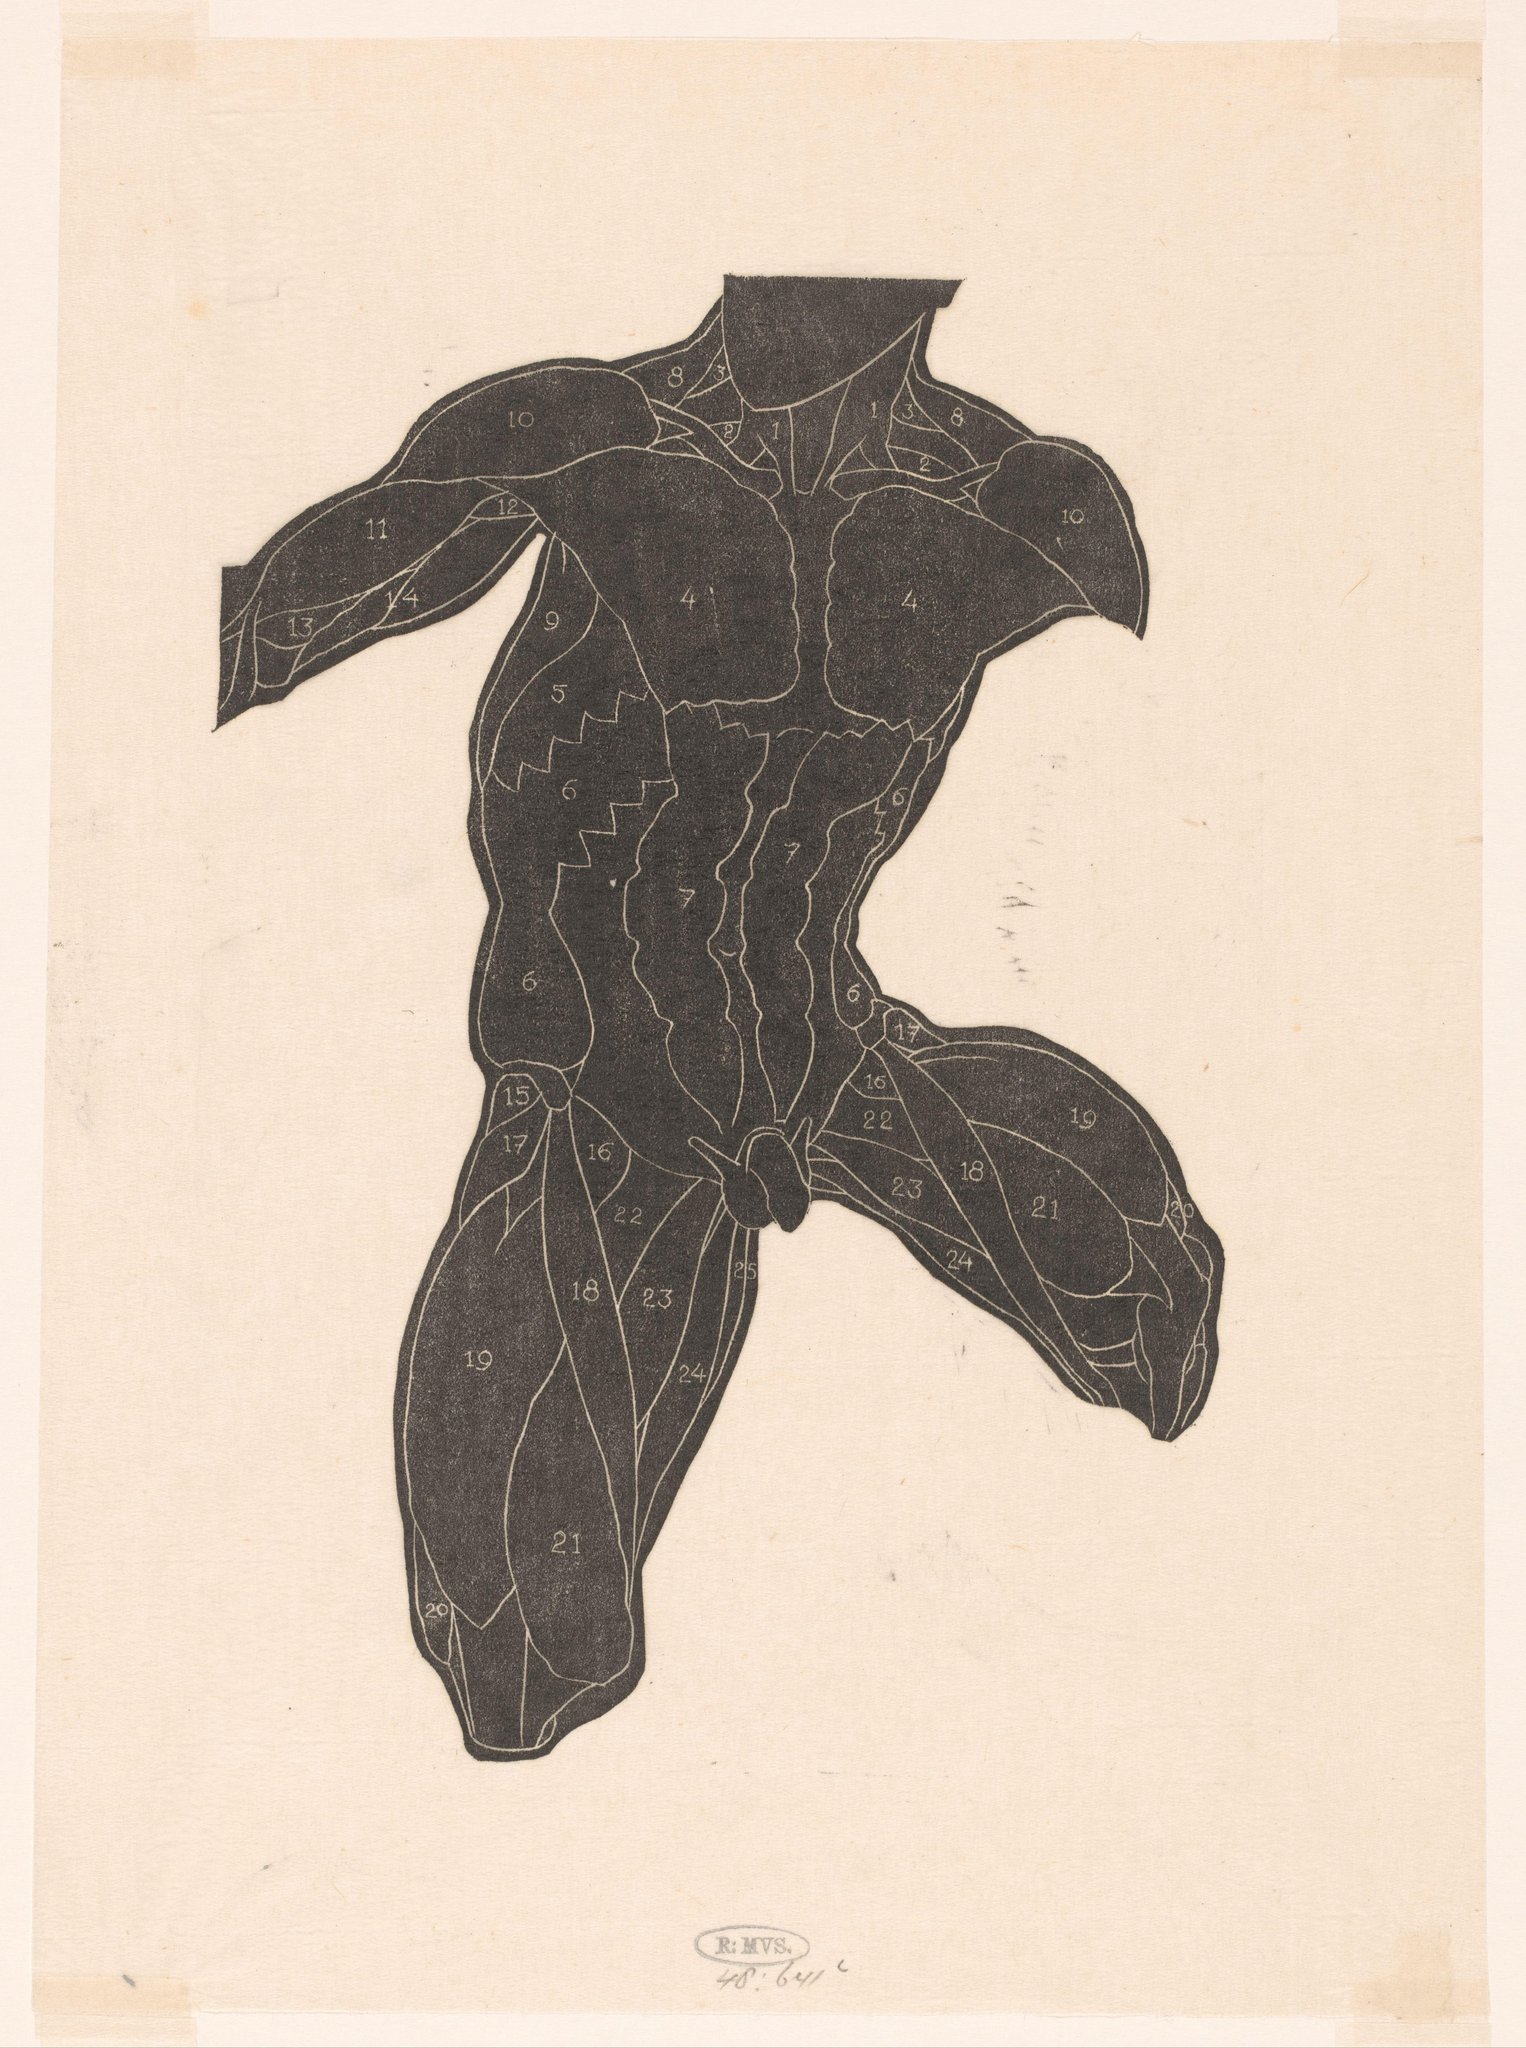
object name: print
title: Anatomische studie van de nek-, buik- en bovenbeenspieren van een man in silhouet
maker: reijer stolk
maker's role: draughtsman, print maker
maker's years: 1896-1945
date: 1906-1945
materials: paper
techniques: woodcut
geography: netherlands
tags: anatomical model of the muscles, muscle-man, 'écorché'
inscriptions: collector's mark: Lugt 2228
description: Prent gebruikt voor: Stolk, Reyer. Anatomische studies in houtsneden. Amsterdam: G.W. Breughel, 1946, plaat 7.